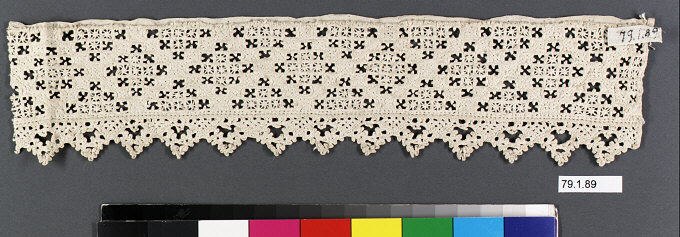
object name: band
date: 1501-1600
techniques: embroidery